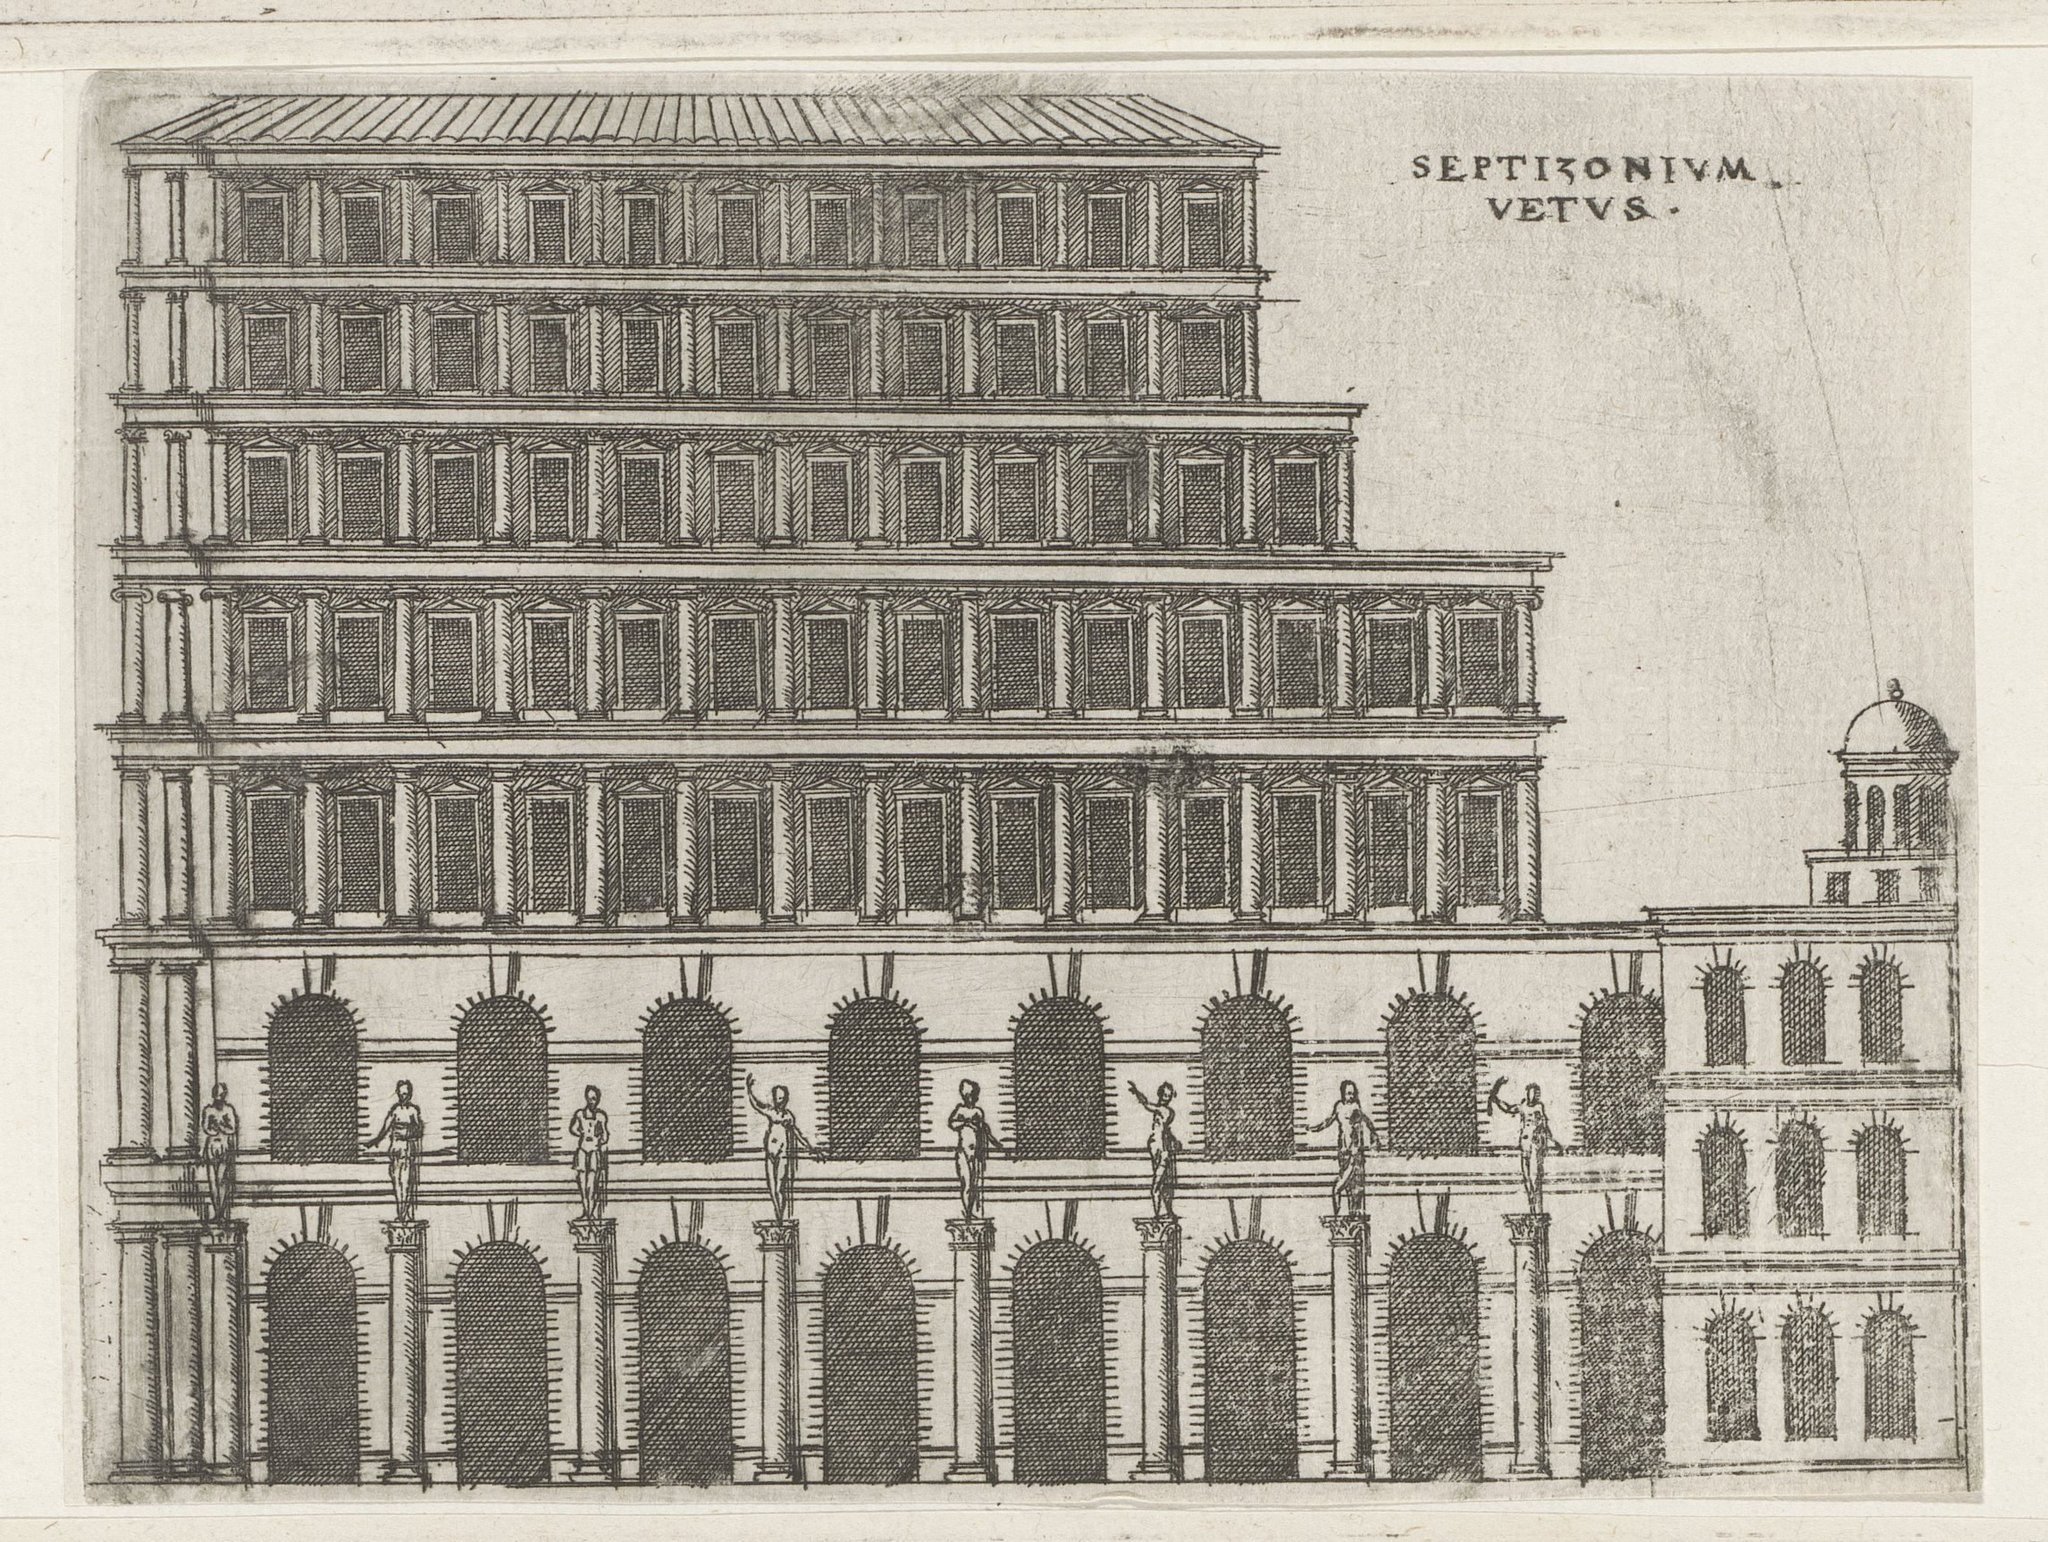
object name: print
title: Magesyn der Italiaense gebouwen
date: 1584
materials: paper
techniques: etching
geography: paris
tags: representation of real building (either existing or having existed)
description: Deze prent maakt deel uit van een serie van 98 prenten gedrukt op 48 bladen. De bladen zijn verknipt en een selectie van de losse prenten is in dit album geplakt.